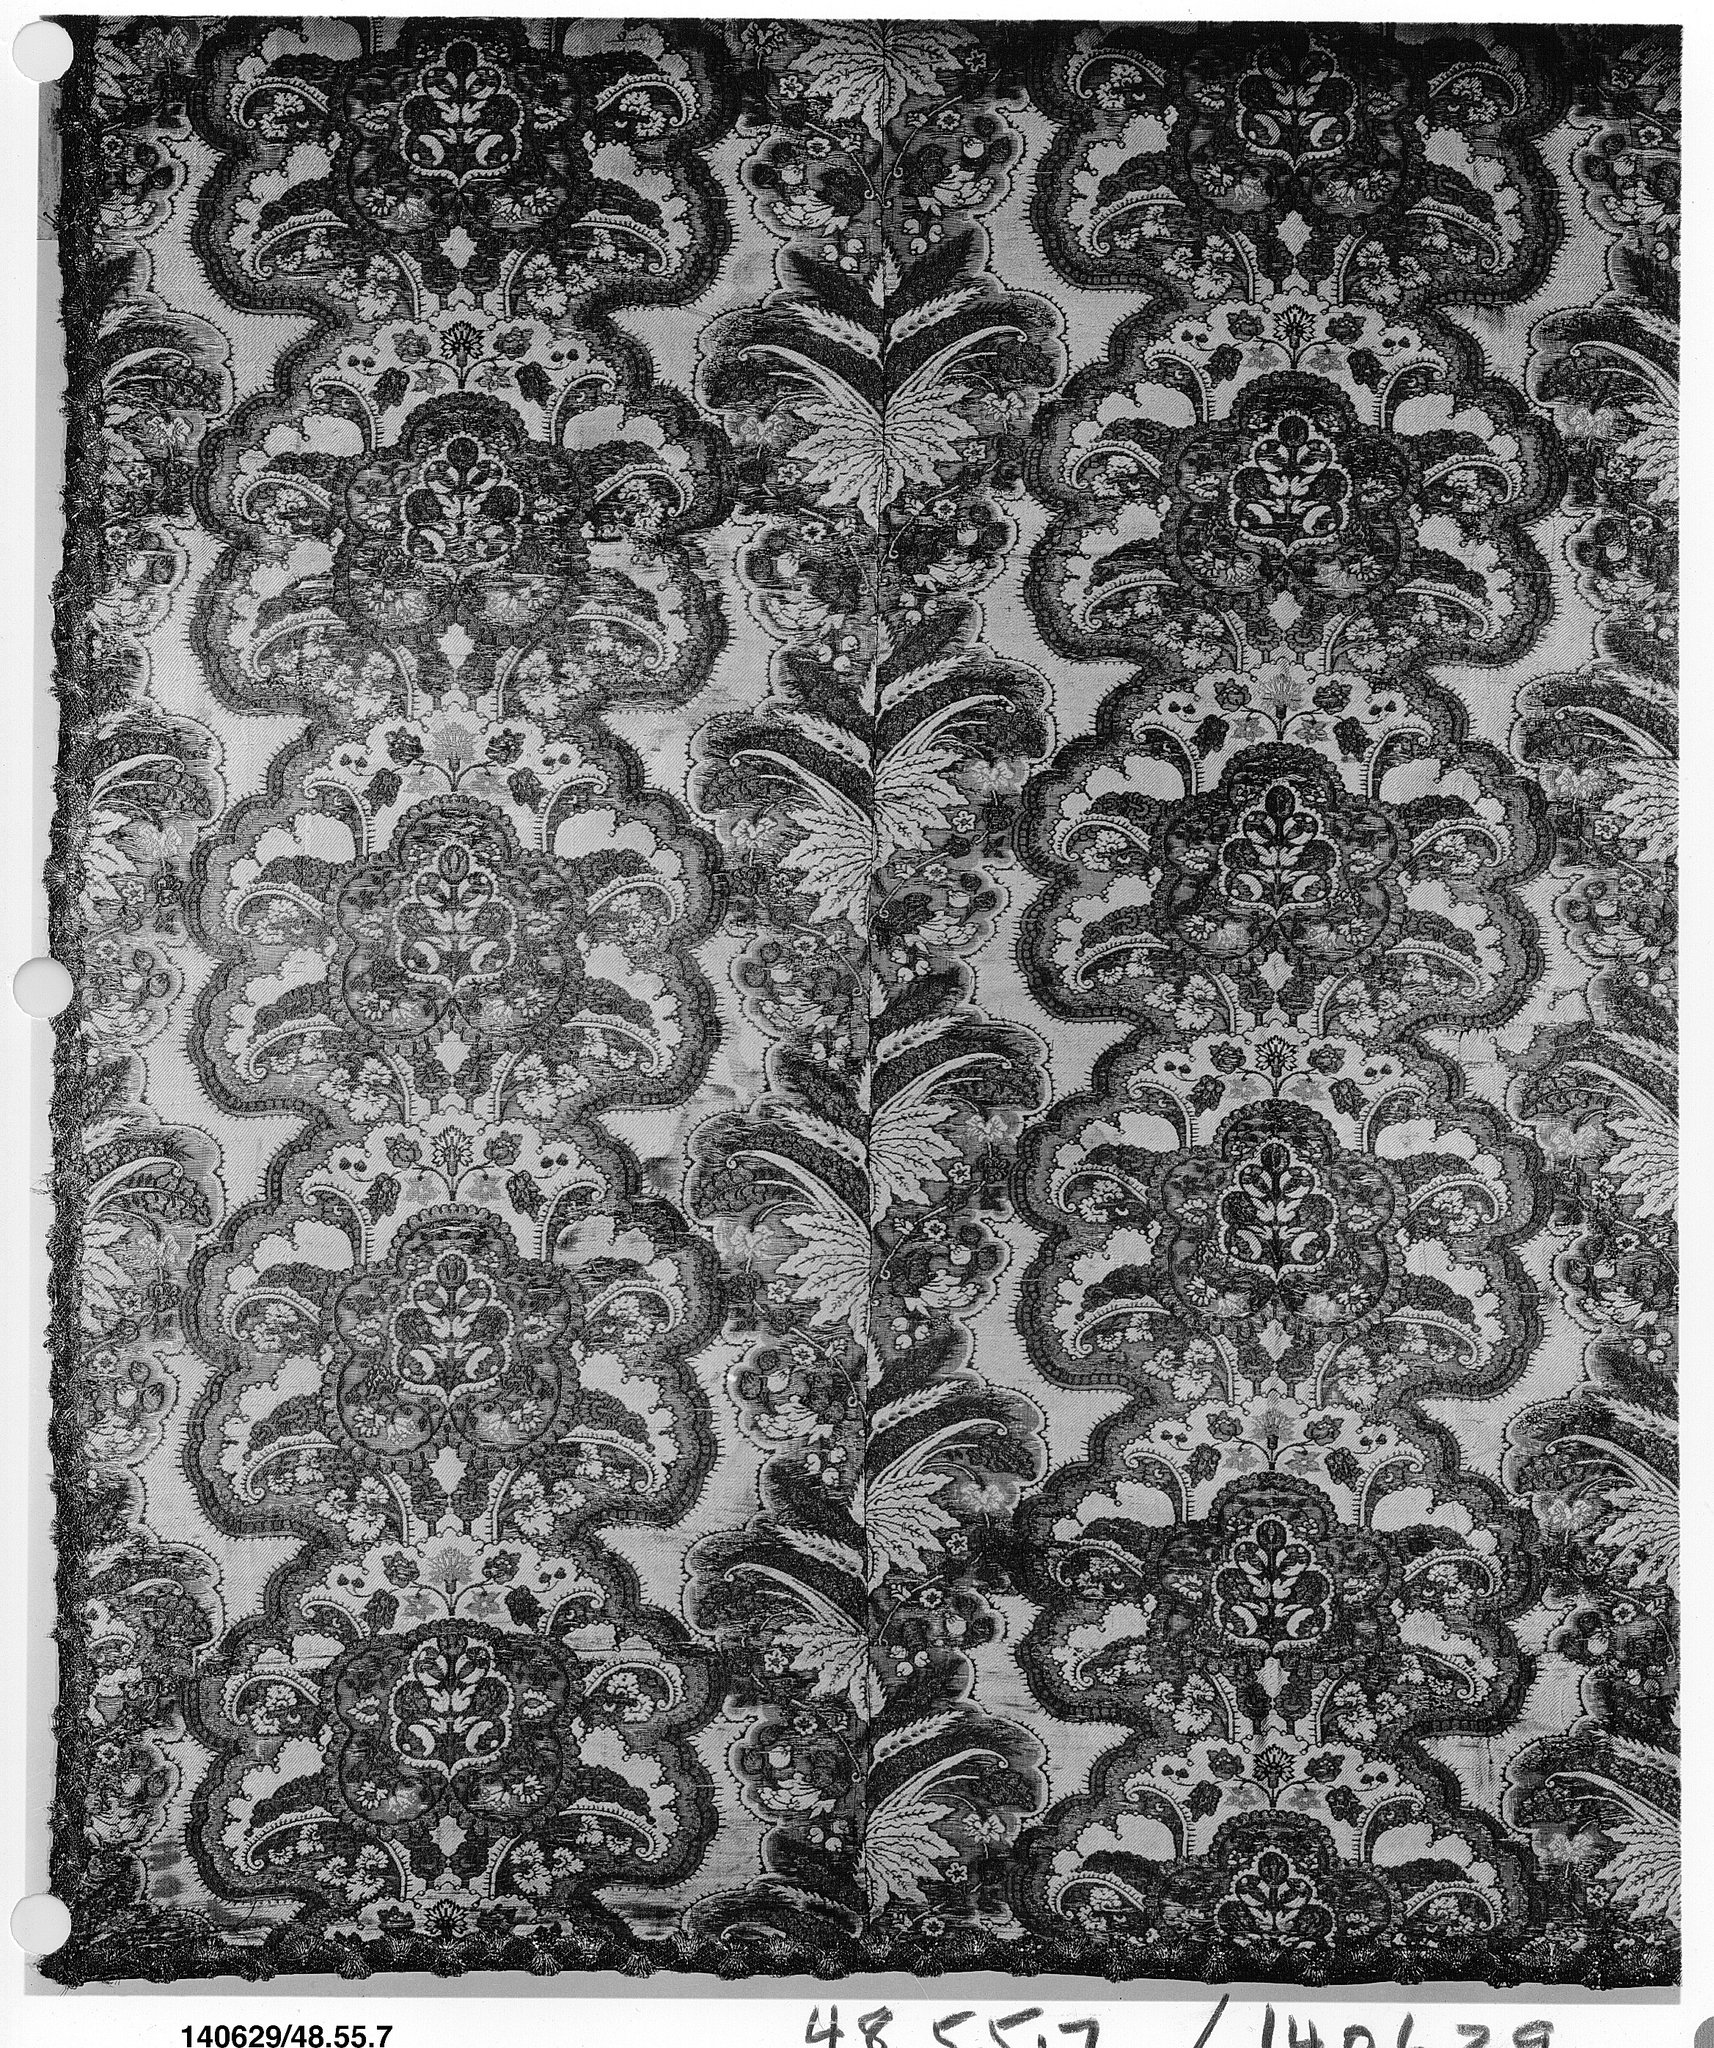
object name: piece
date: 1701-1733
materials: metal thread, silk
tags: leaves